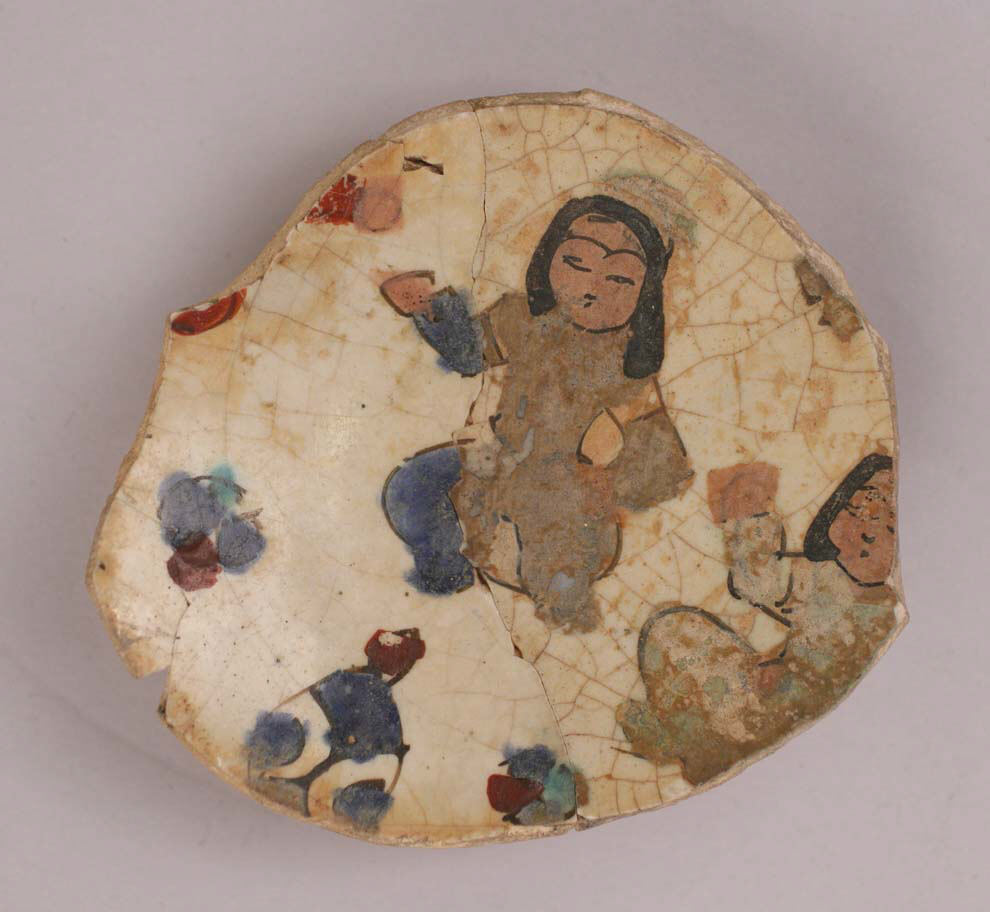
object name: fragment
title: Fragment of a Bowl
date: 1101-1300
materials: stonepaste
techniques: overglaze, painting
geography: iran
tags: human figures